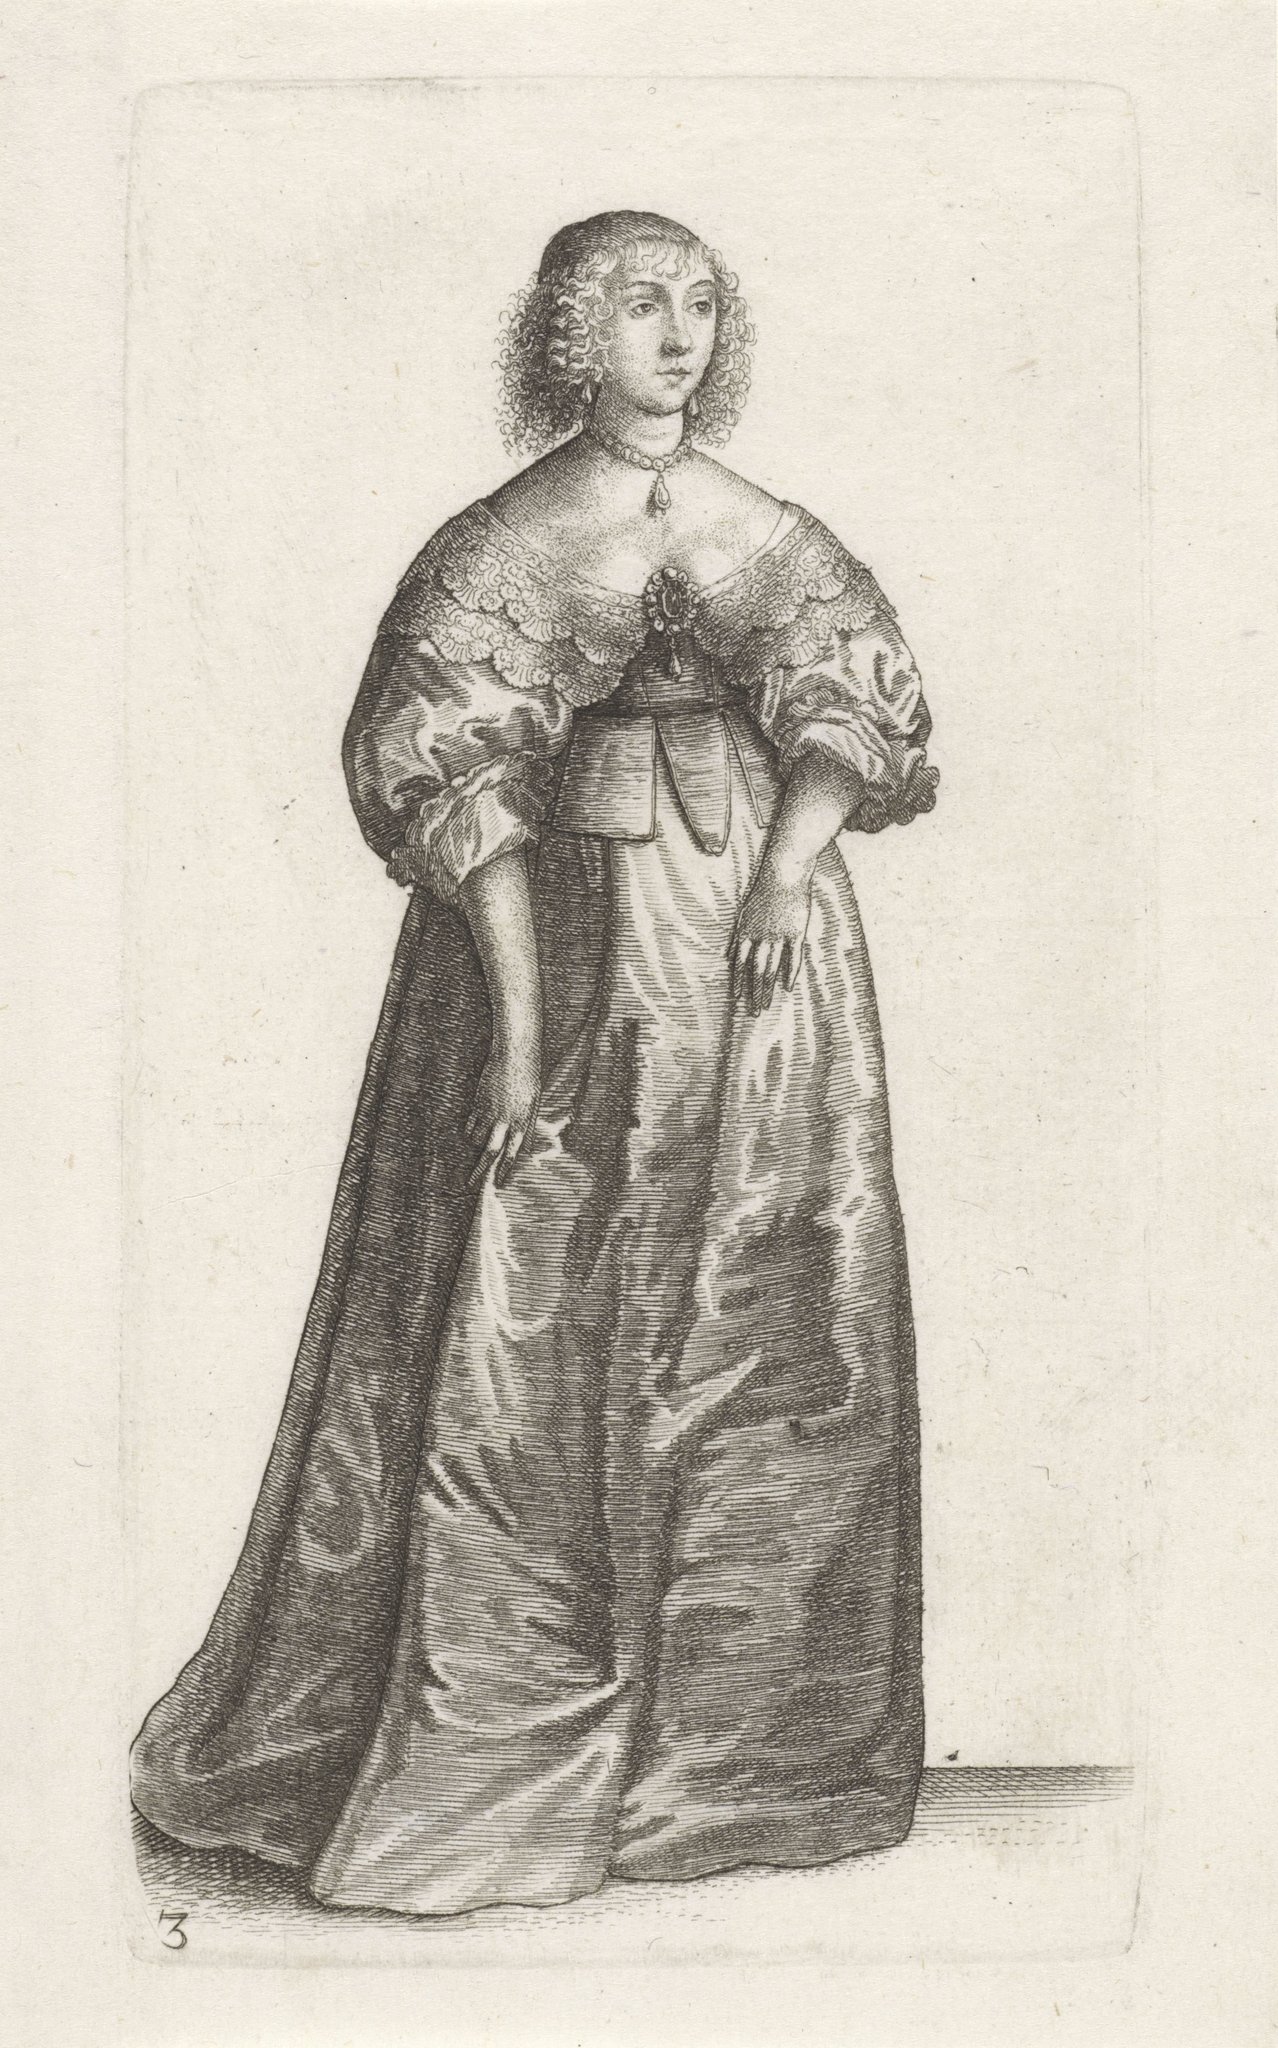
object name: costume print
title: Vrouwen gekleed volgens de Engelse mode, ca. 1640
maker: wenceslaus hollar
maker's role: draughtsman, print maker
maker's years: 1607-1677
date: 1638-1640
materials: paper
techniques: etching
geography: london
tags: pendant, trinket, 'breloque' (+ women's clothes), brooch, agraffe, clasp (+ women's clothes), europeans: englishmen (+ women), styles of hairdress - aa - ~ women, neck-gear: collar (+ women's clothes), fashion plates, clothes, costume (+ women's clothes), skirt (+ women's clothes), sleeves: cuffs (+ women's clothes), dress, gown (+ women's clothes), sleeves (+ women's clothes), necklace (+ women's clothes), clothing for the upper part of the body (with name) (+ women's clothes), england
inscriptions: collector's mark: Lugt 654, number: ‘3’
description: Engelse dame met haar dat vanaf het voorhoofd strak naar achteren is gekamd en op het achterhoofd eindigt in een ronde wrong met haarnet, maar aan weerszijden van het gezicht met gefriseerde krullen afhangt. Druppelvormige oorhangers en een parelketting met hanger rond de hals. Gekleed in een japon bestaande uit een kort open lijf met lage ronde halsuitsnijding en schoot, hoge taille, wijde mouwen tot net over de elleboog en smal borststuk op een lange, ruime rok enigszins slepend op de grond. In het midden van het decolleté een broche. No. 3 uit de serie Ornatus Muliebris Anglicanus.